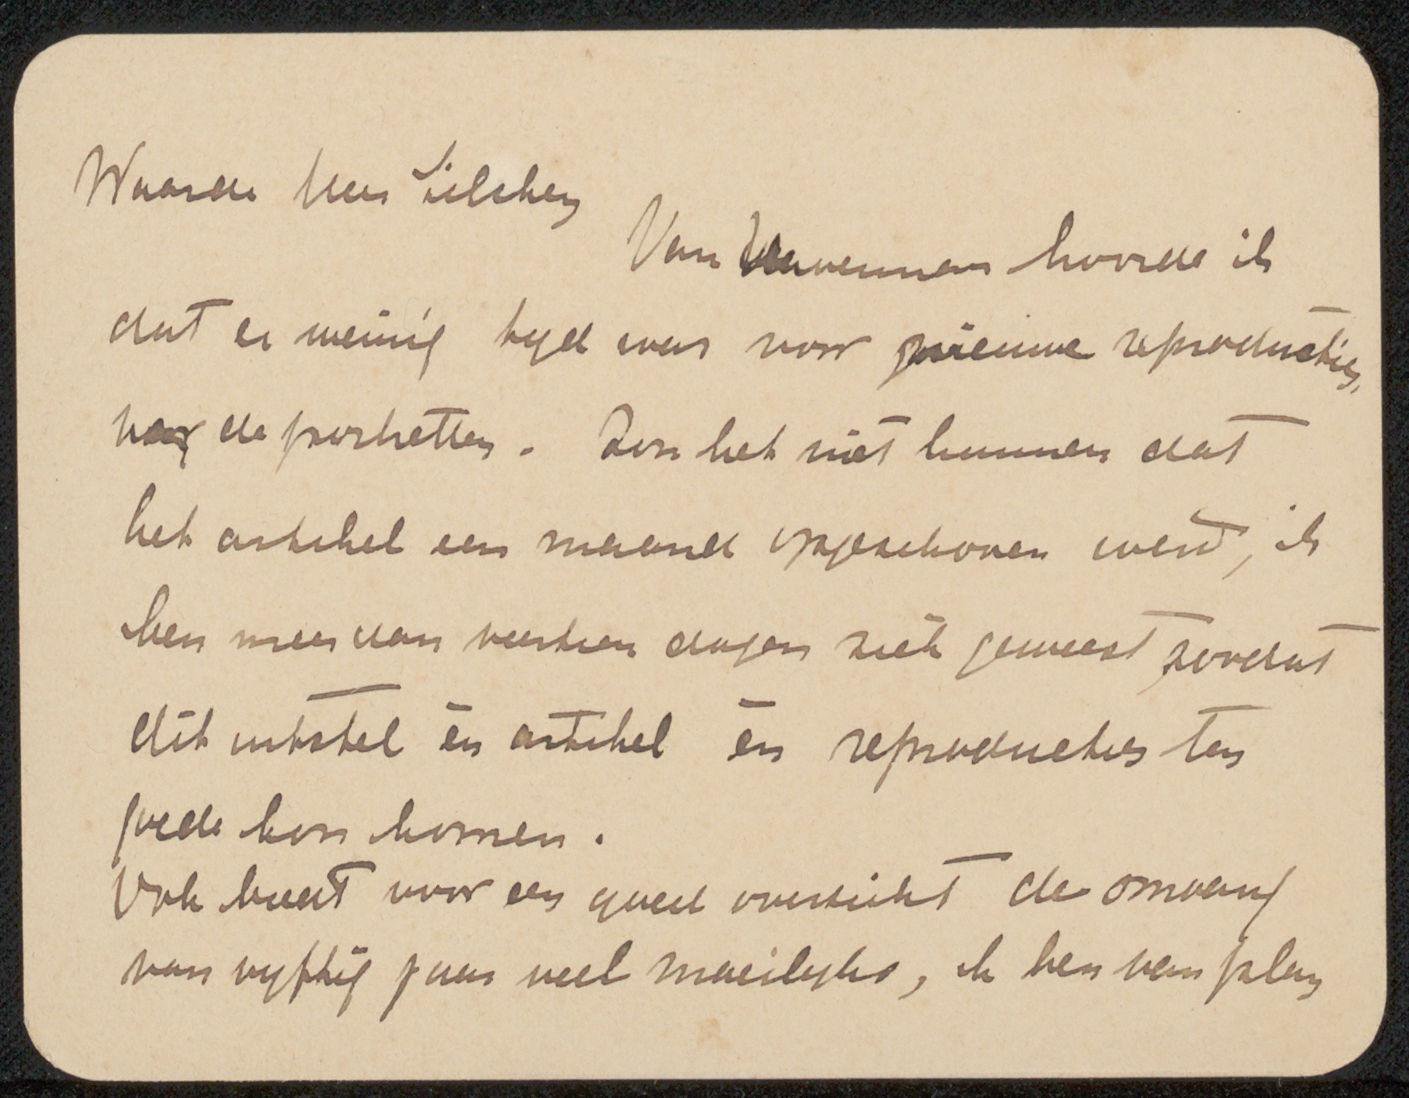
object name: letter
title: Brief aan Philip Zilcken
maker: grada hermina marius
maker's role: painter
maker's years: 1854-1919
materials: cardboard, ink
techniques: pen, writing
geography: the hague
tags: amsterdam, painter, print maker, draughtsman, nicolaas pieneman, jan adam kruseman, hendrik johannes haverman, philip zilcken, anonymous historical person portrayed, printed matter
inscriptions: collector's mark: ‘RPK’